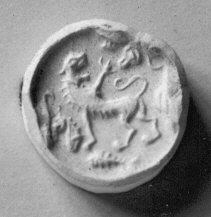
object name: stamp seal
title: Conoid seal with hammer head handle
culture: assyrian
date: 2000-1668 BCE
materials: quartzite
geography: anatolia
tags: animals